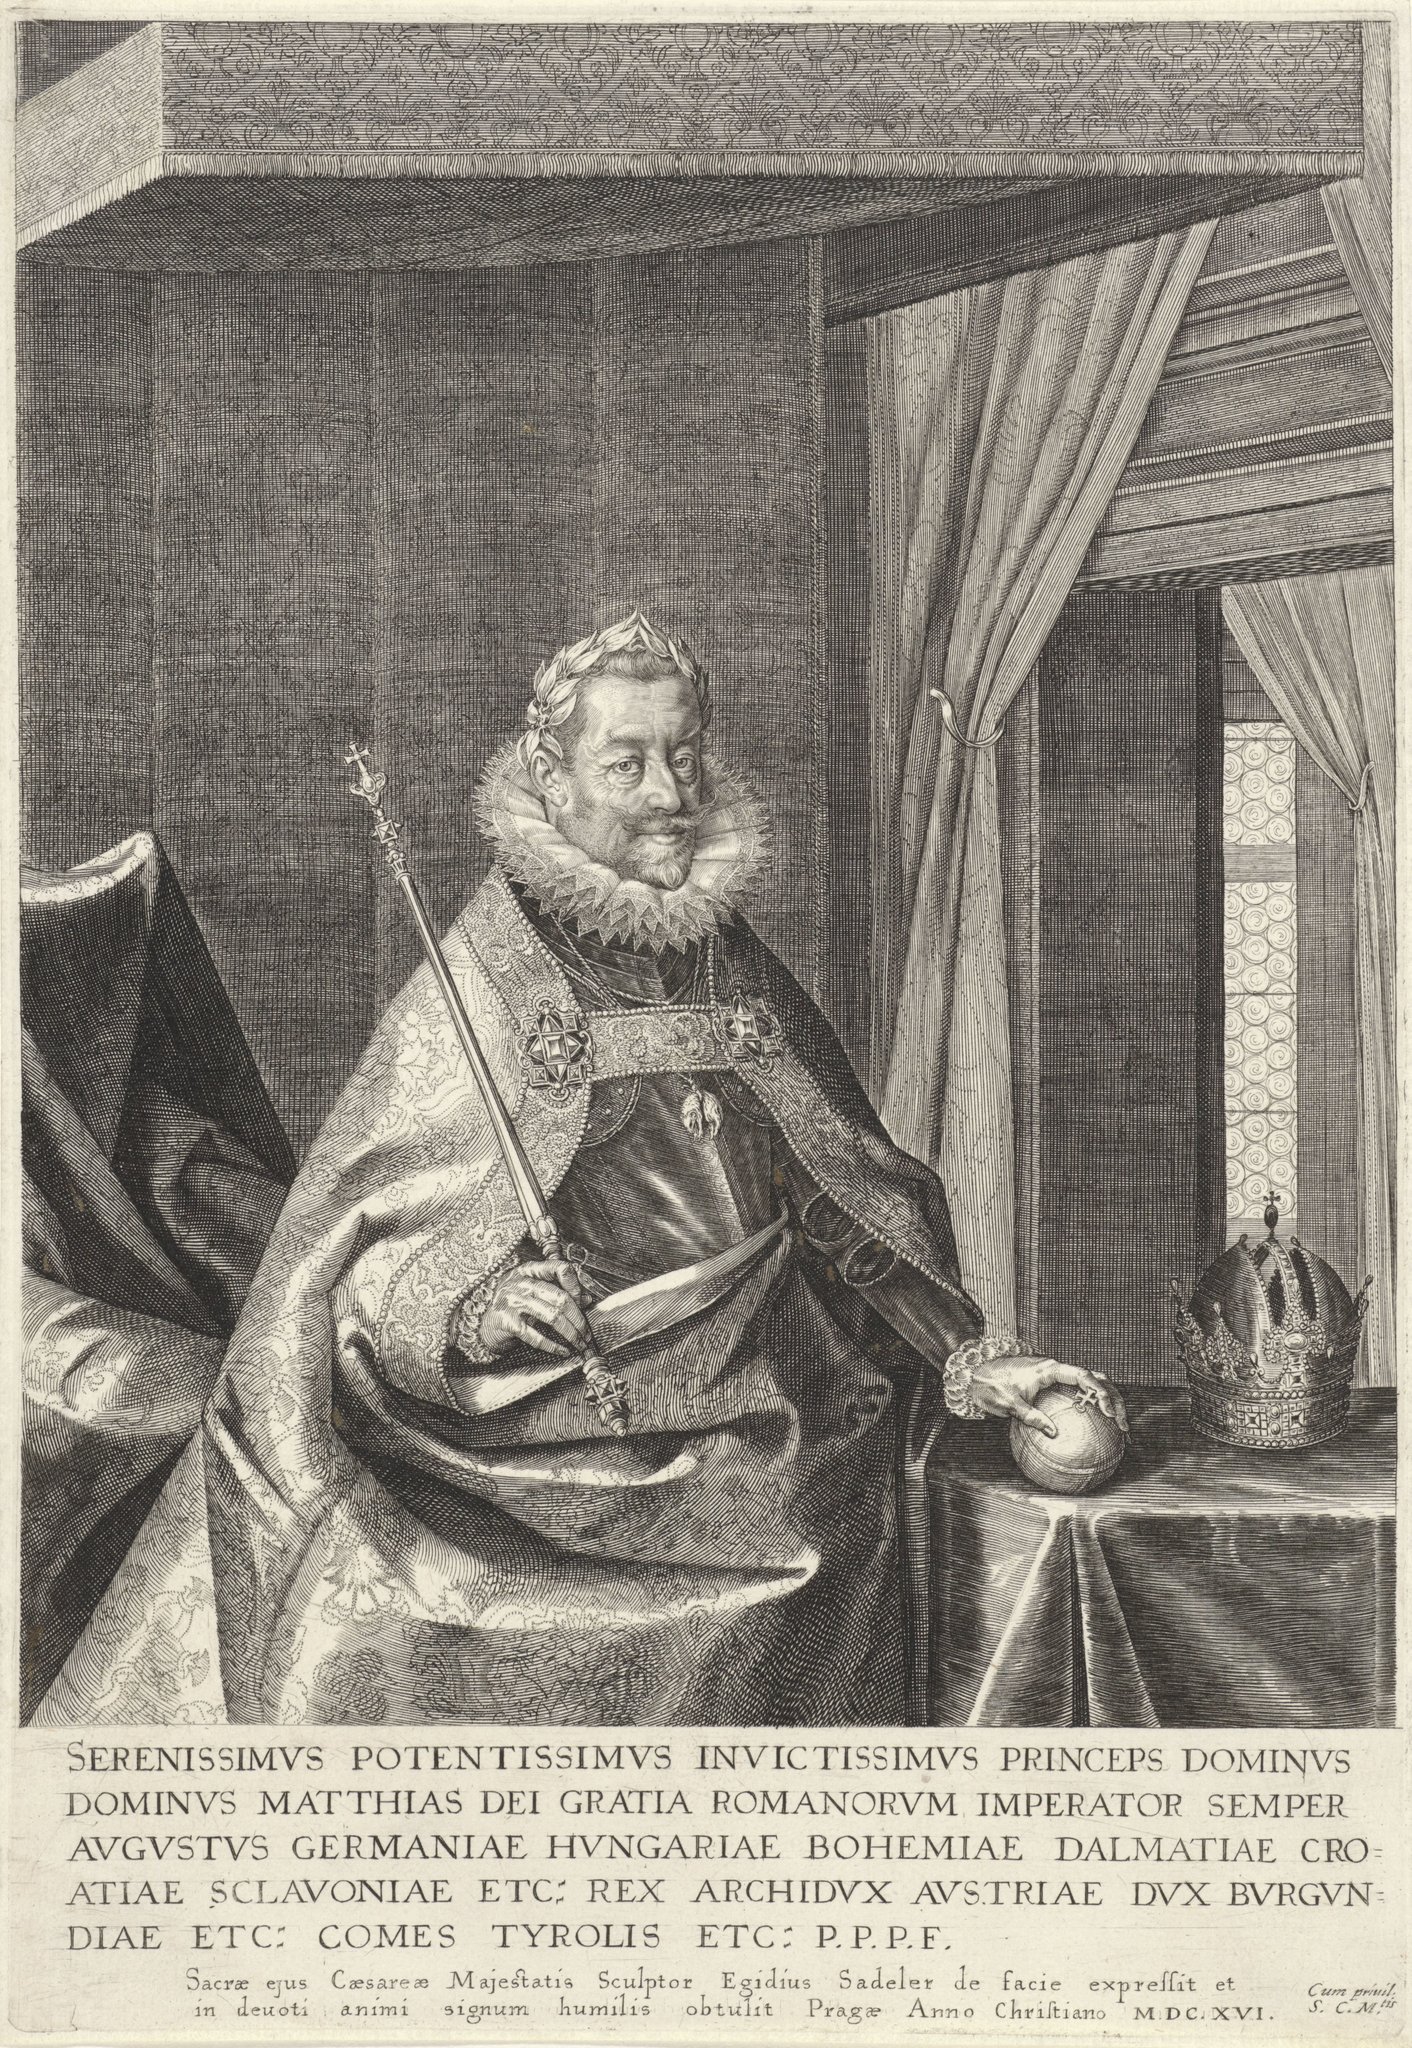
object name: print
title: Portret van keizer Matthias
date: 1616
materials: paper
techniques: engraving, etching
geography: prague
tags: matthias van oostenrijk (rooms-duits keizer), crown (symbol of sovereignty), orb (symbol of sovereignty; sphere with cross on top), sceptre, staff (symbol of sovereignty), emperor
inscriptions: collector's mark: Lugt 2228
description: Matthias van Oostenrijk, keizer van het Heilig Roomse Rijk. Hij houdt in zijn linkerhand de rijksappel vast. In zijn rechterhand de keizerlijke scepter. Op een tafel naast hem de keizerlijke kroon.